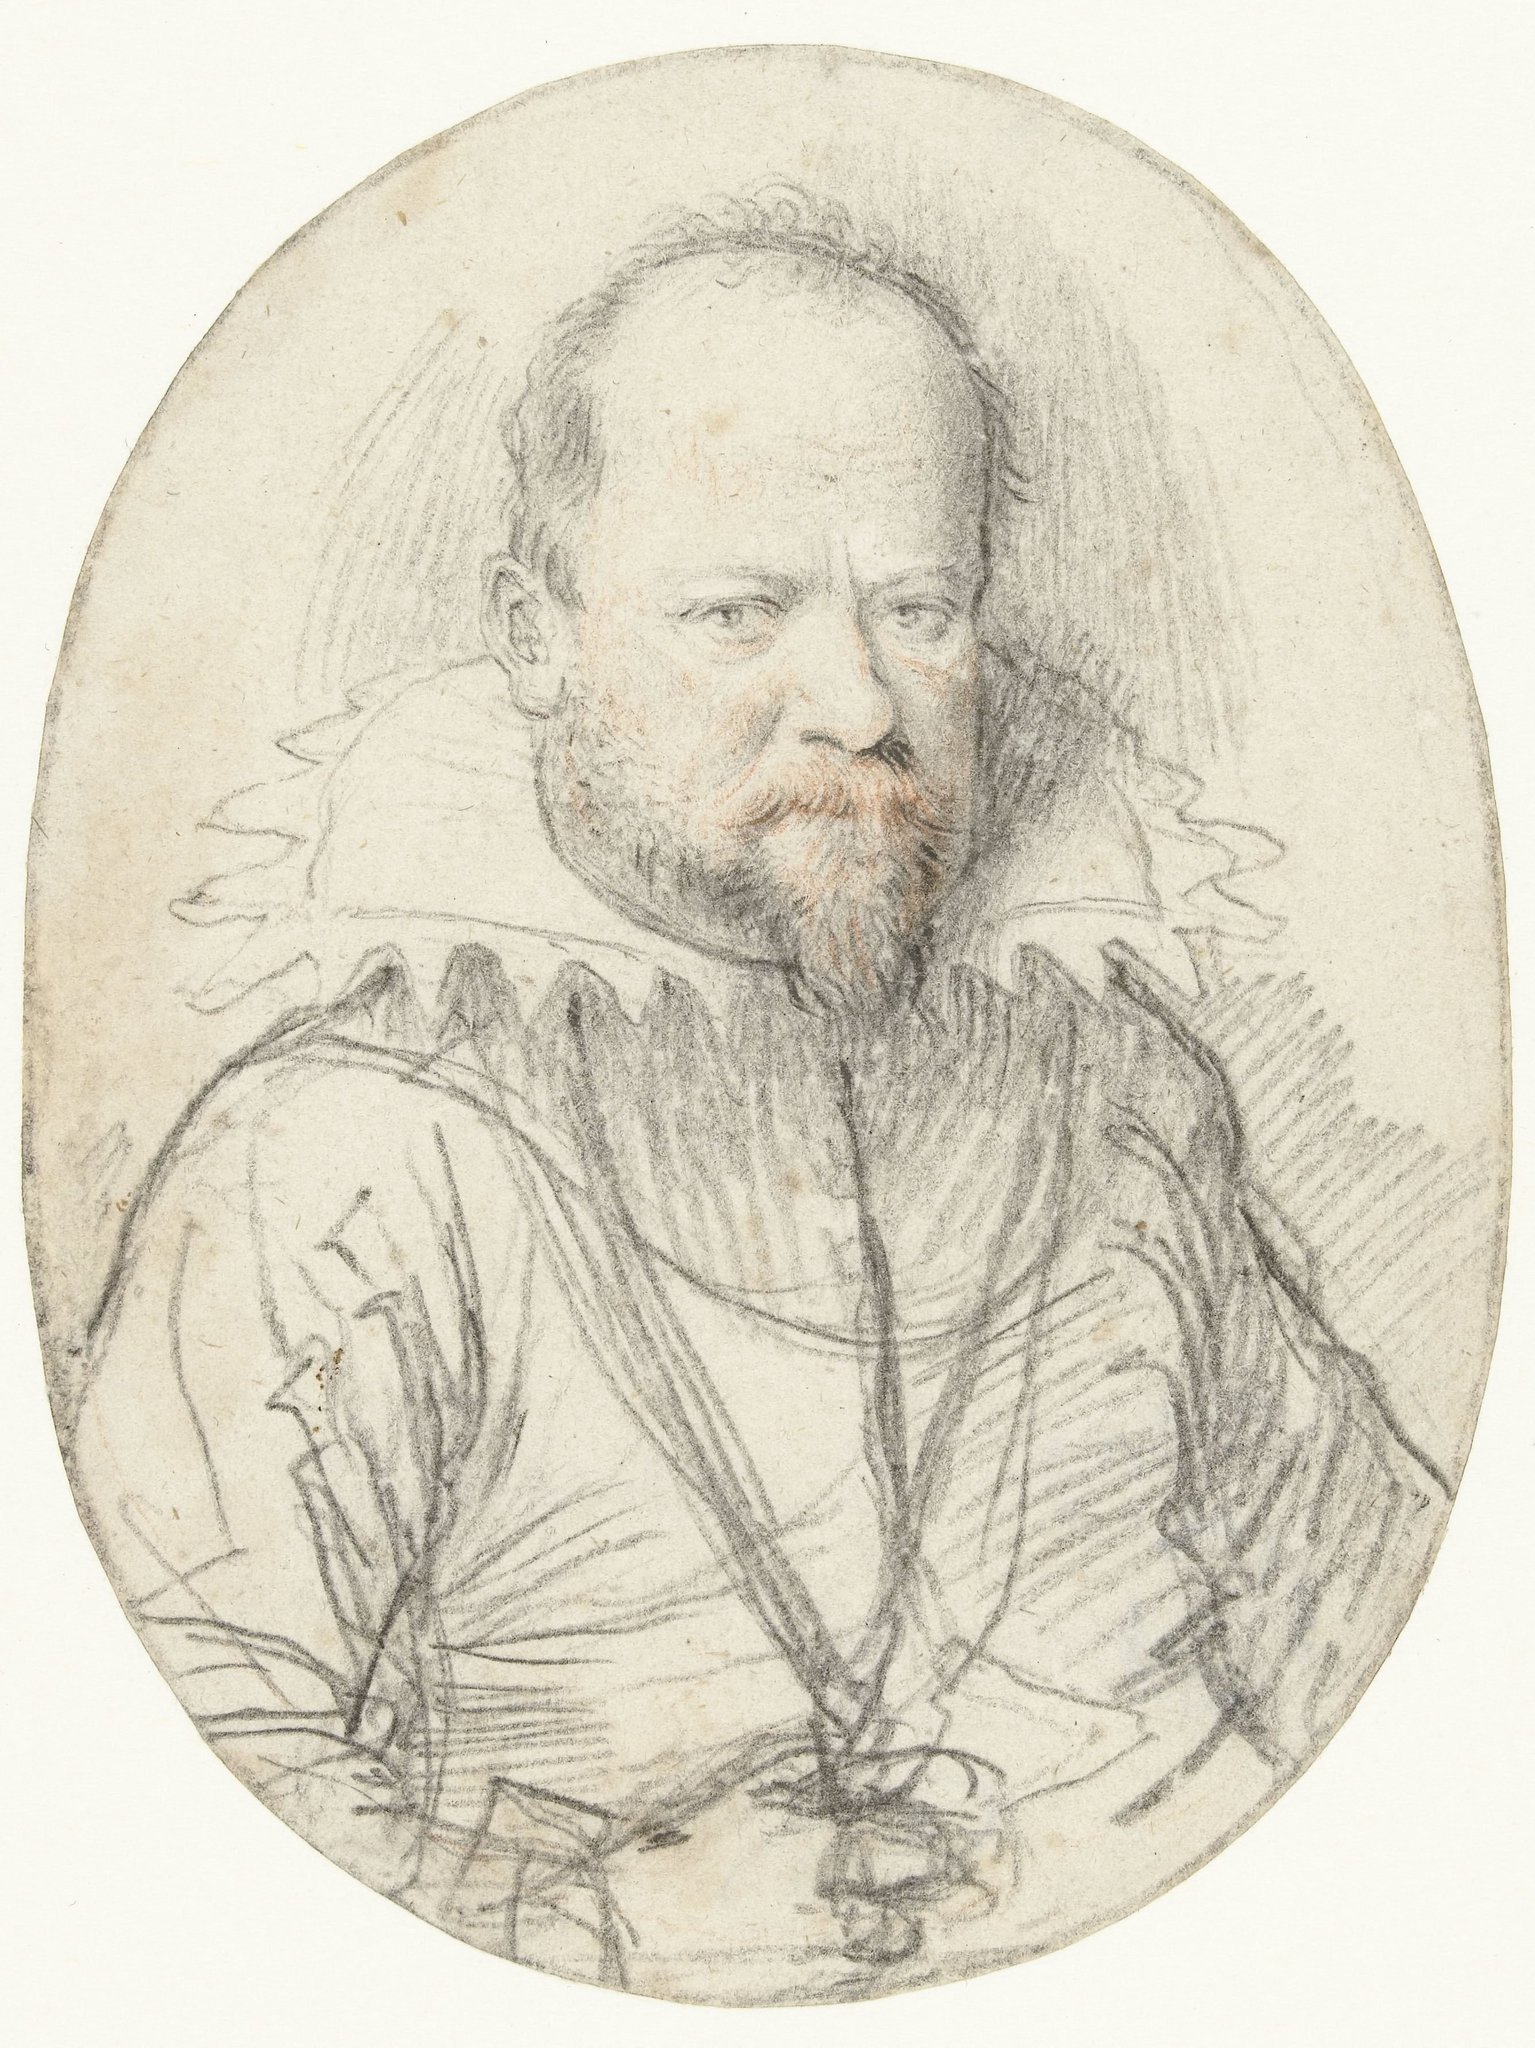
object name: drawing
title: Portret van Gundacker Von Polheim (1575-1644)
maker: aegidius sadeler (ii)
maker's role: draughtsman, print maker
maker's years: 1568-1629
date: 1580-1629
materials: chalk, paper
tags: historical persons